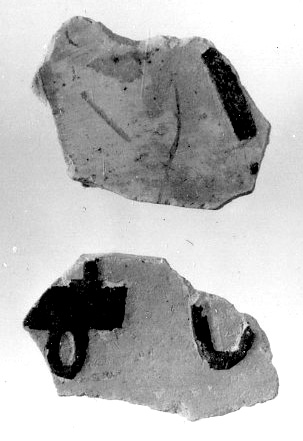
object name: relief fragment, tomb of meketre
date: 1981-1975 BCE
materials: limestone, paint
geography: egypt